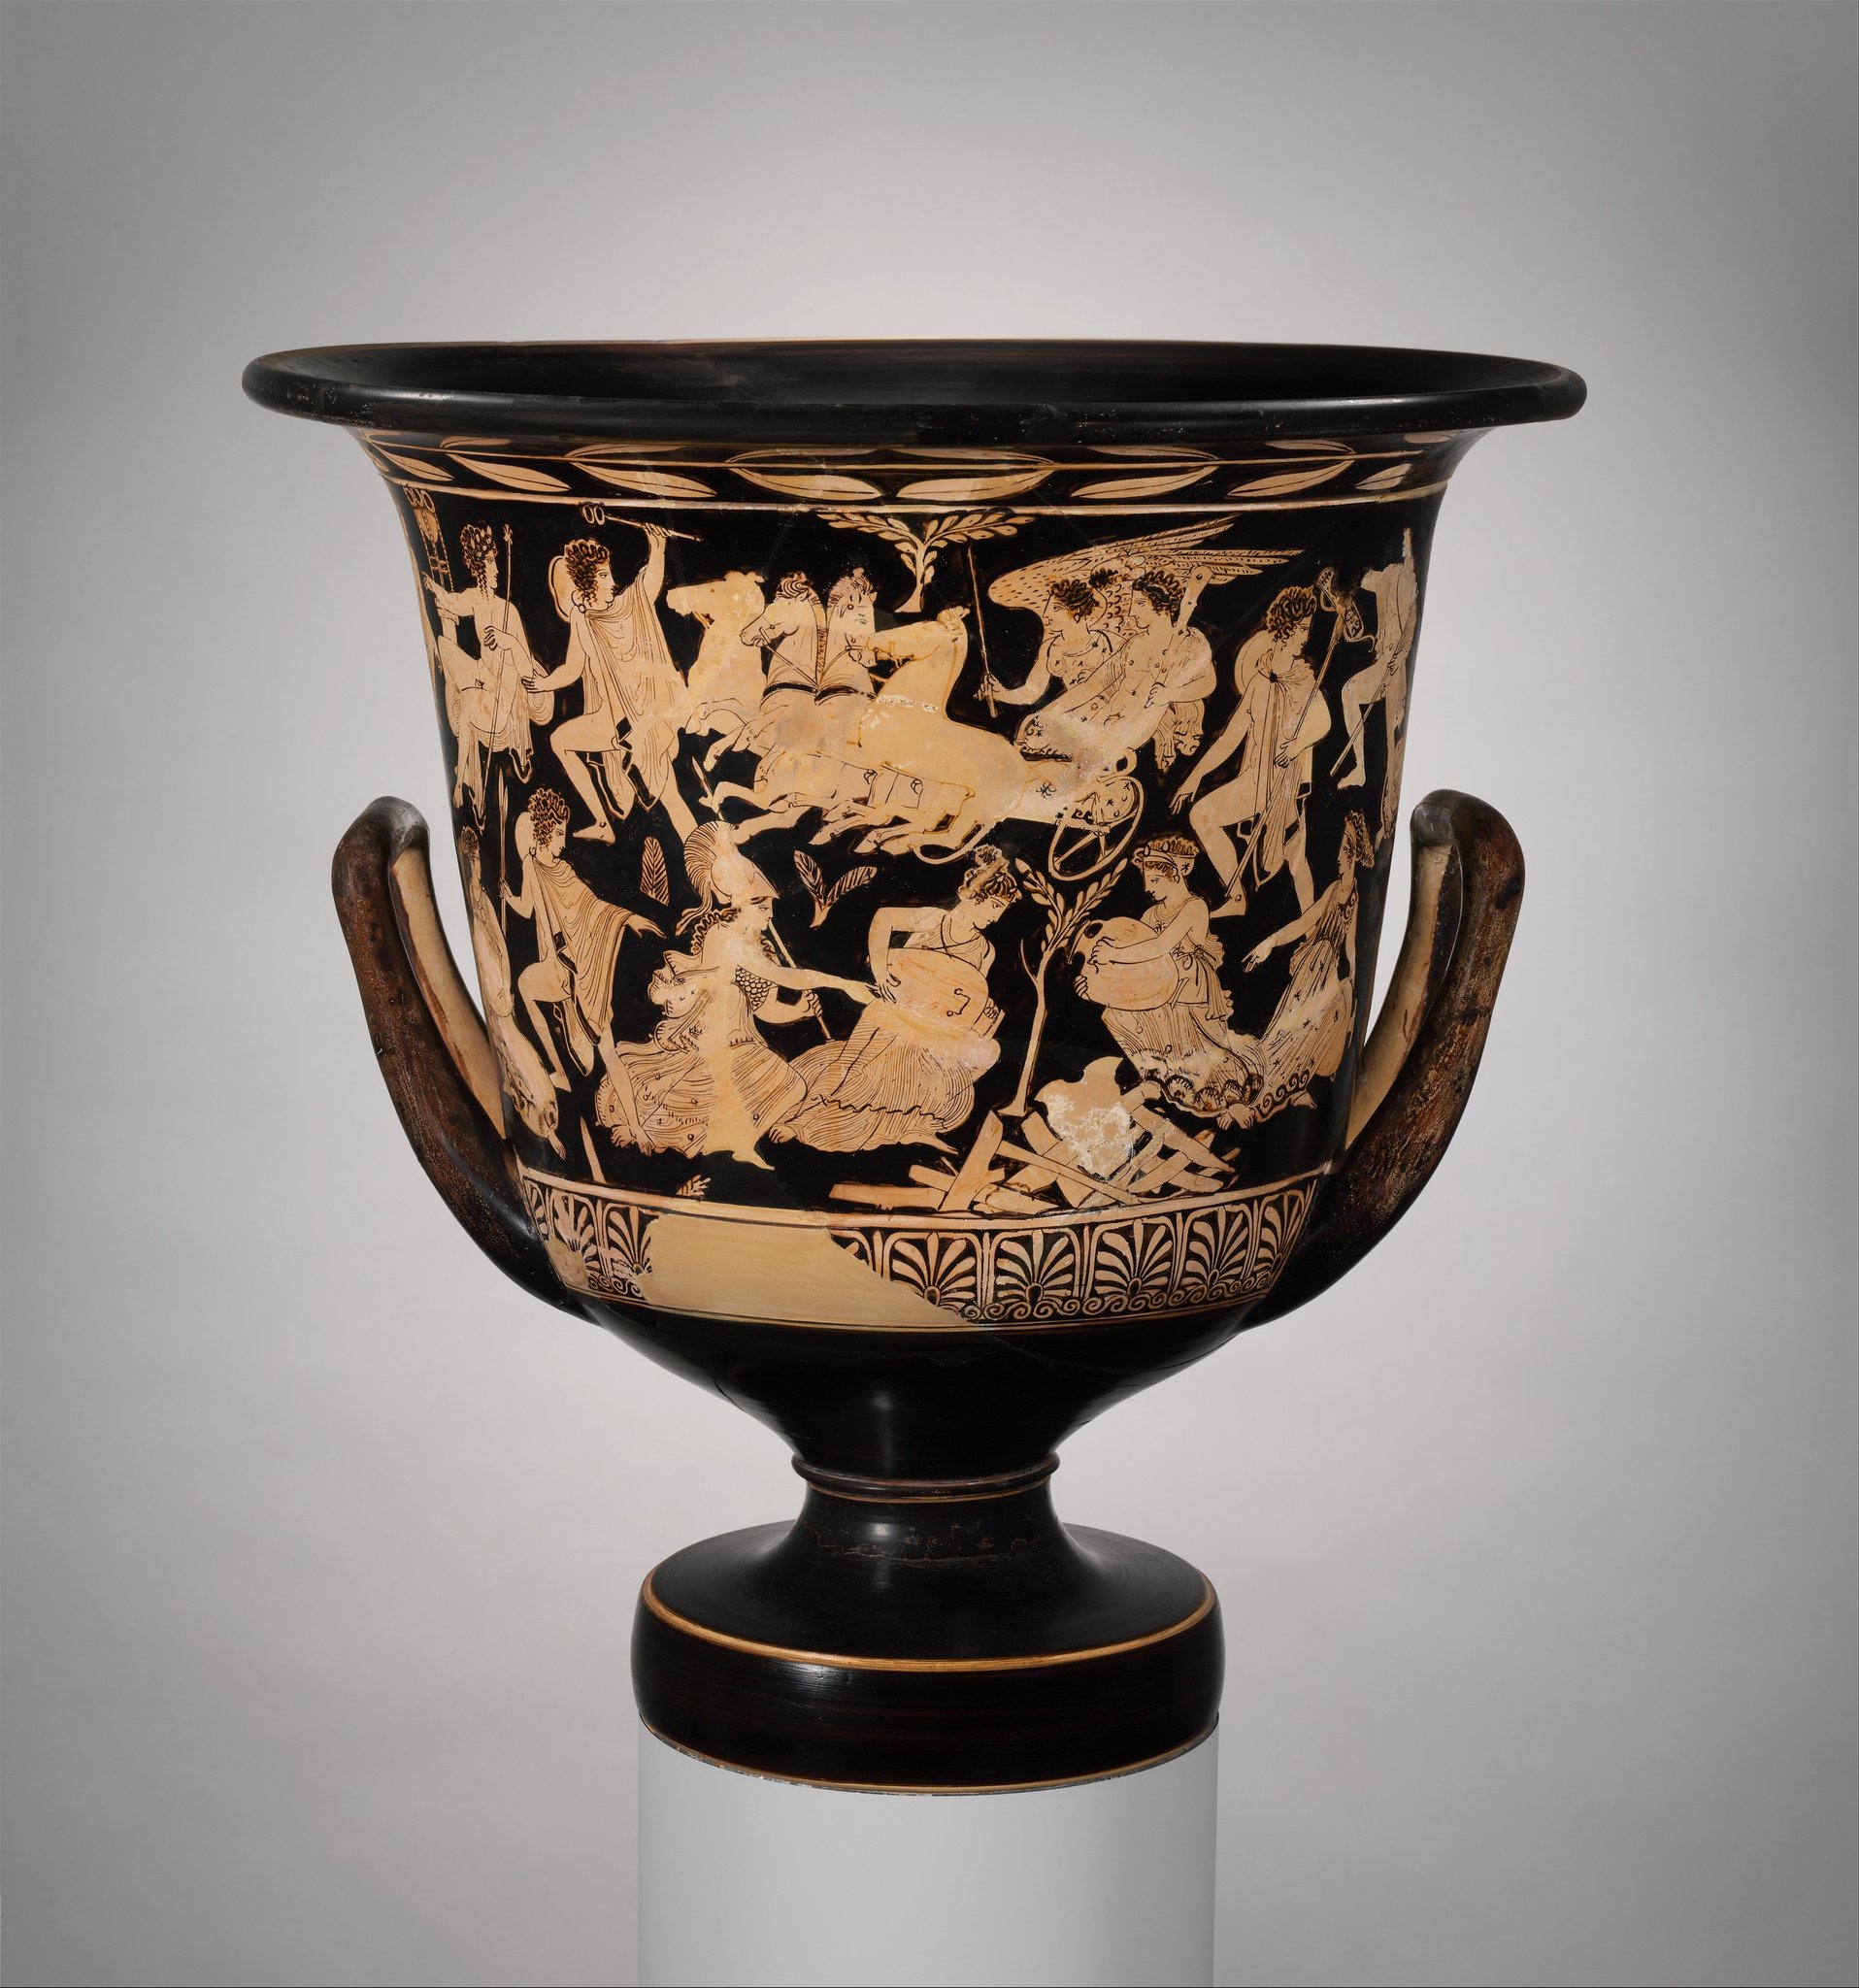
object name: calyx krater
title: Terracotta calyx-krater (bowl for mixing wine and water)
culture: greek, attic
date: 400-301 BCE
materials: terracotta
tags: athena,satyrs,horses,chariots